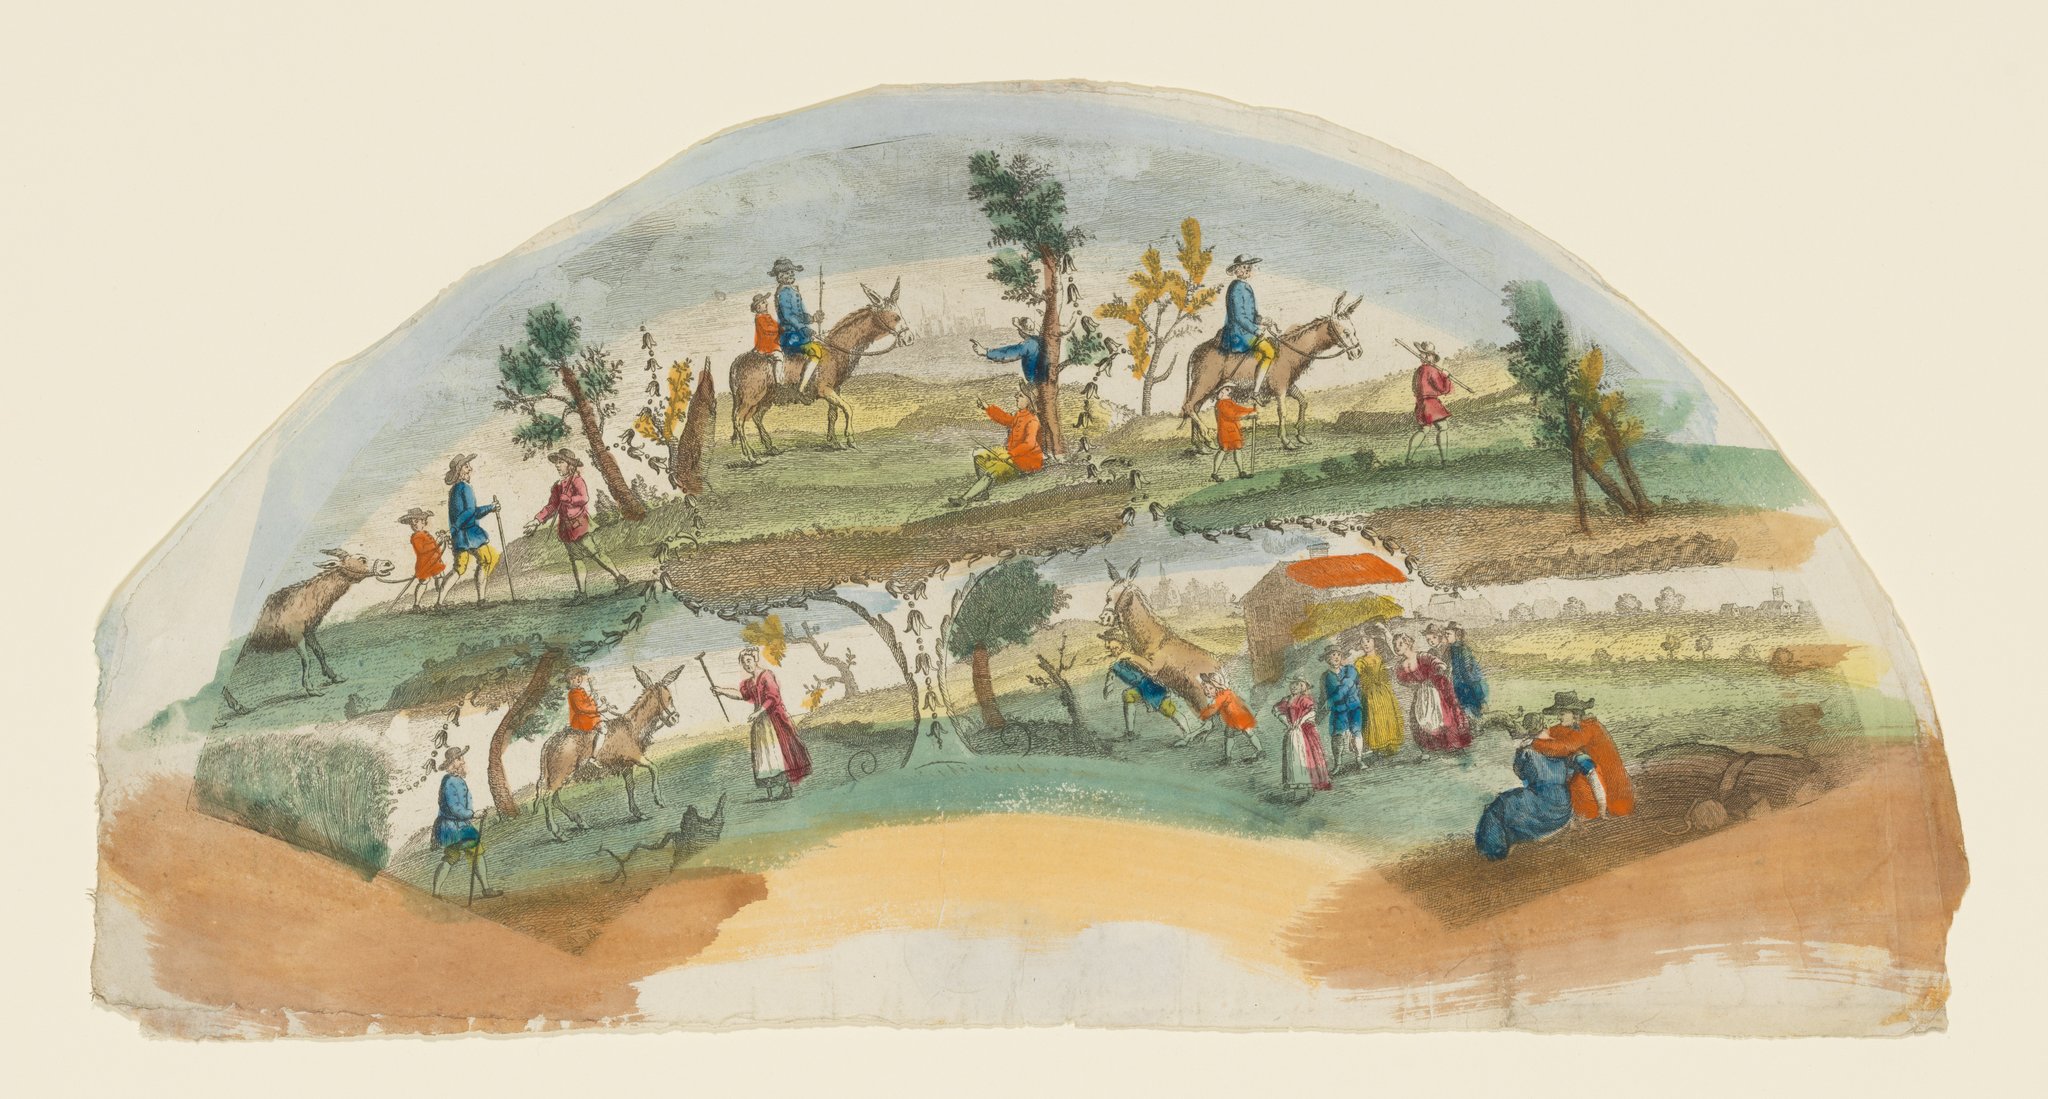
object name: print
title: Fan design, donkeys and people in the countryside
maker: anonymous, british, 18th century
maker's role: artist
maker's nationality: british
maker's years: 1700-1800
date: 1701-1800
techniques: etching